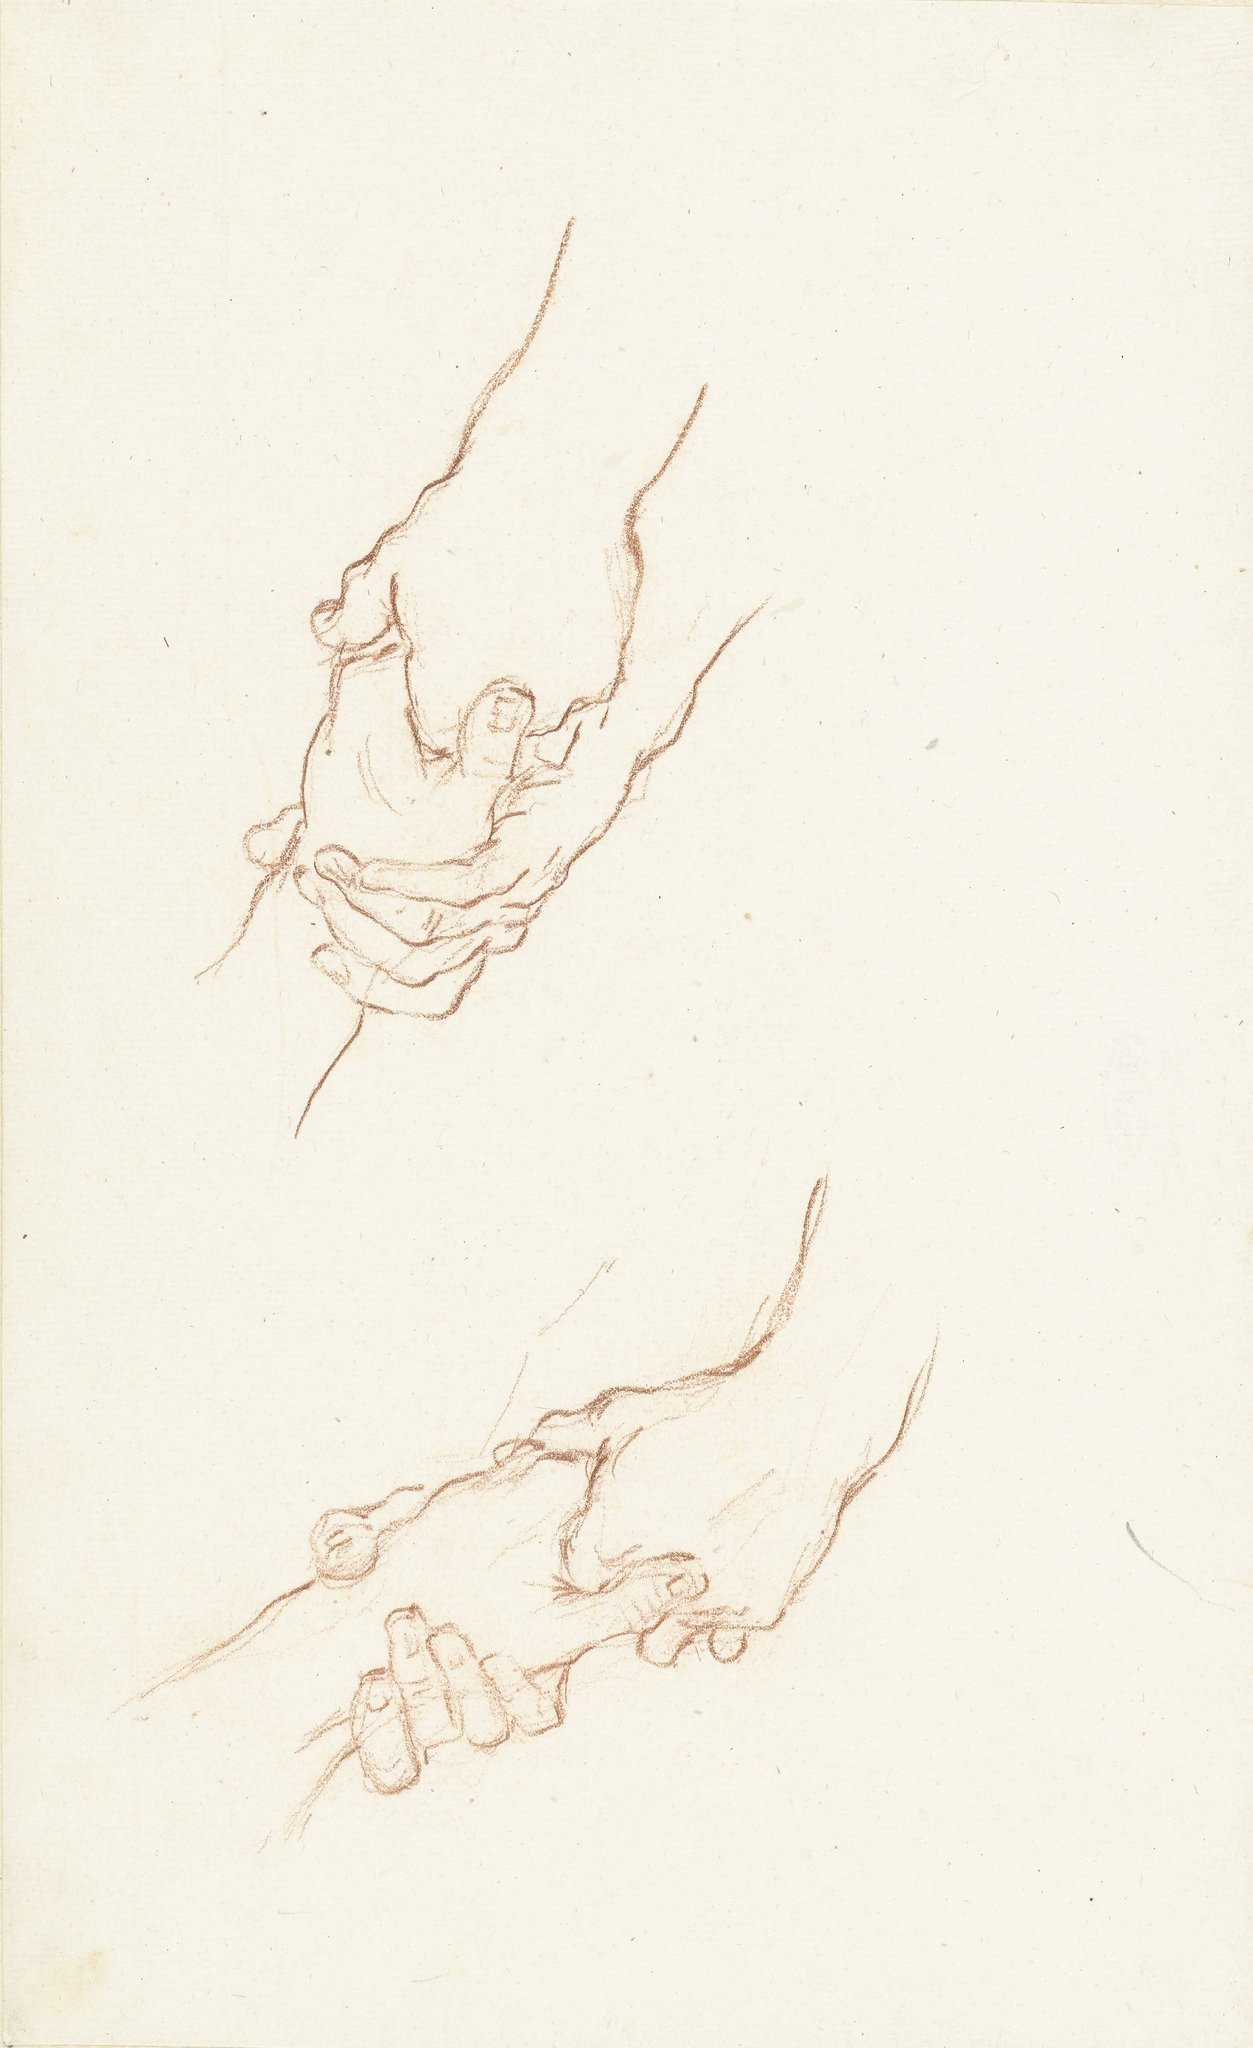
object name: drawing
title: Twee studies van een hand aangevat door andere handen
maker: bernard picart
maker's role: draughtsman, print maker, publisher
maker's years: 1673-1733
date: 1683-1733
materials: chalk, paper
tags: hand